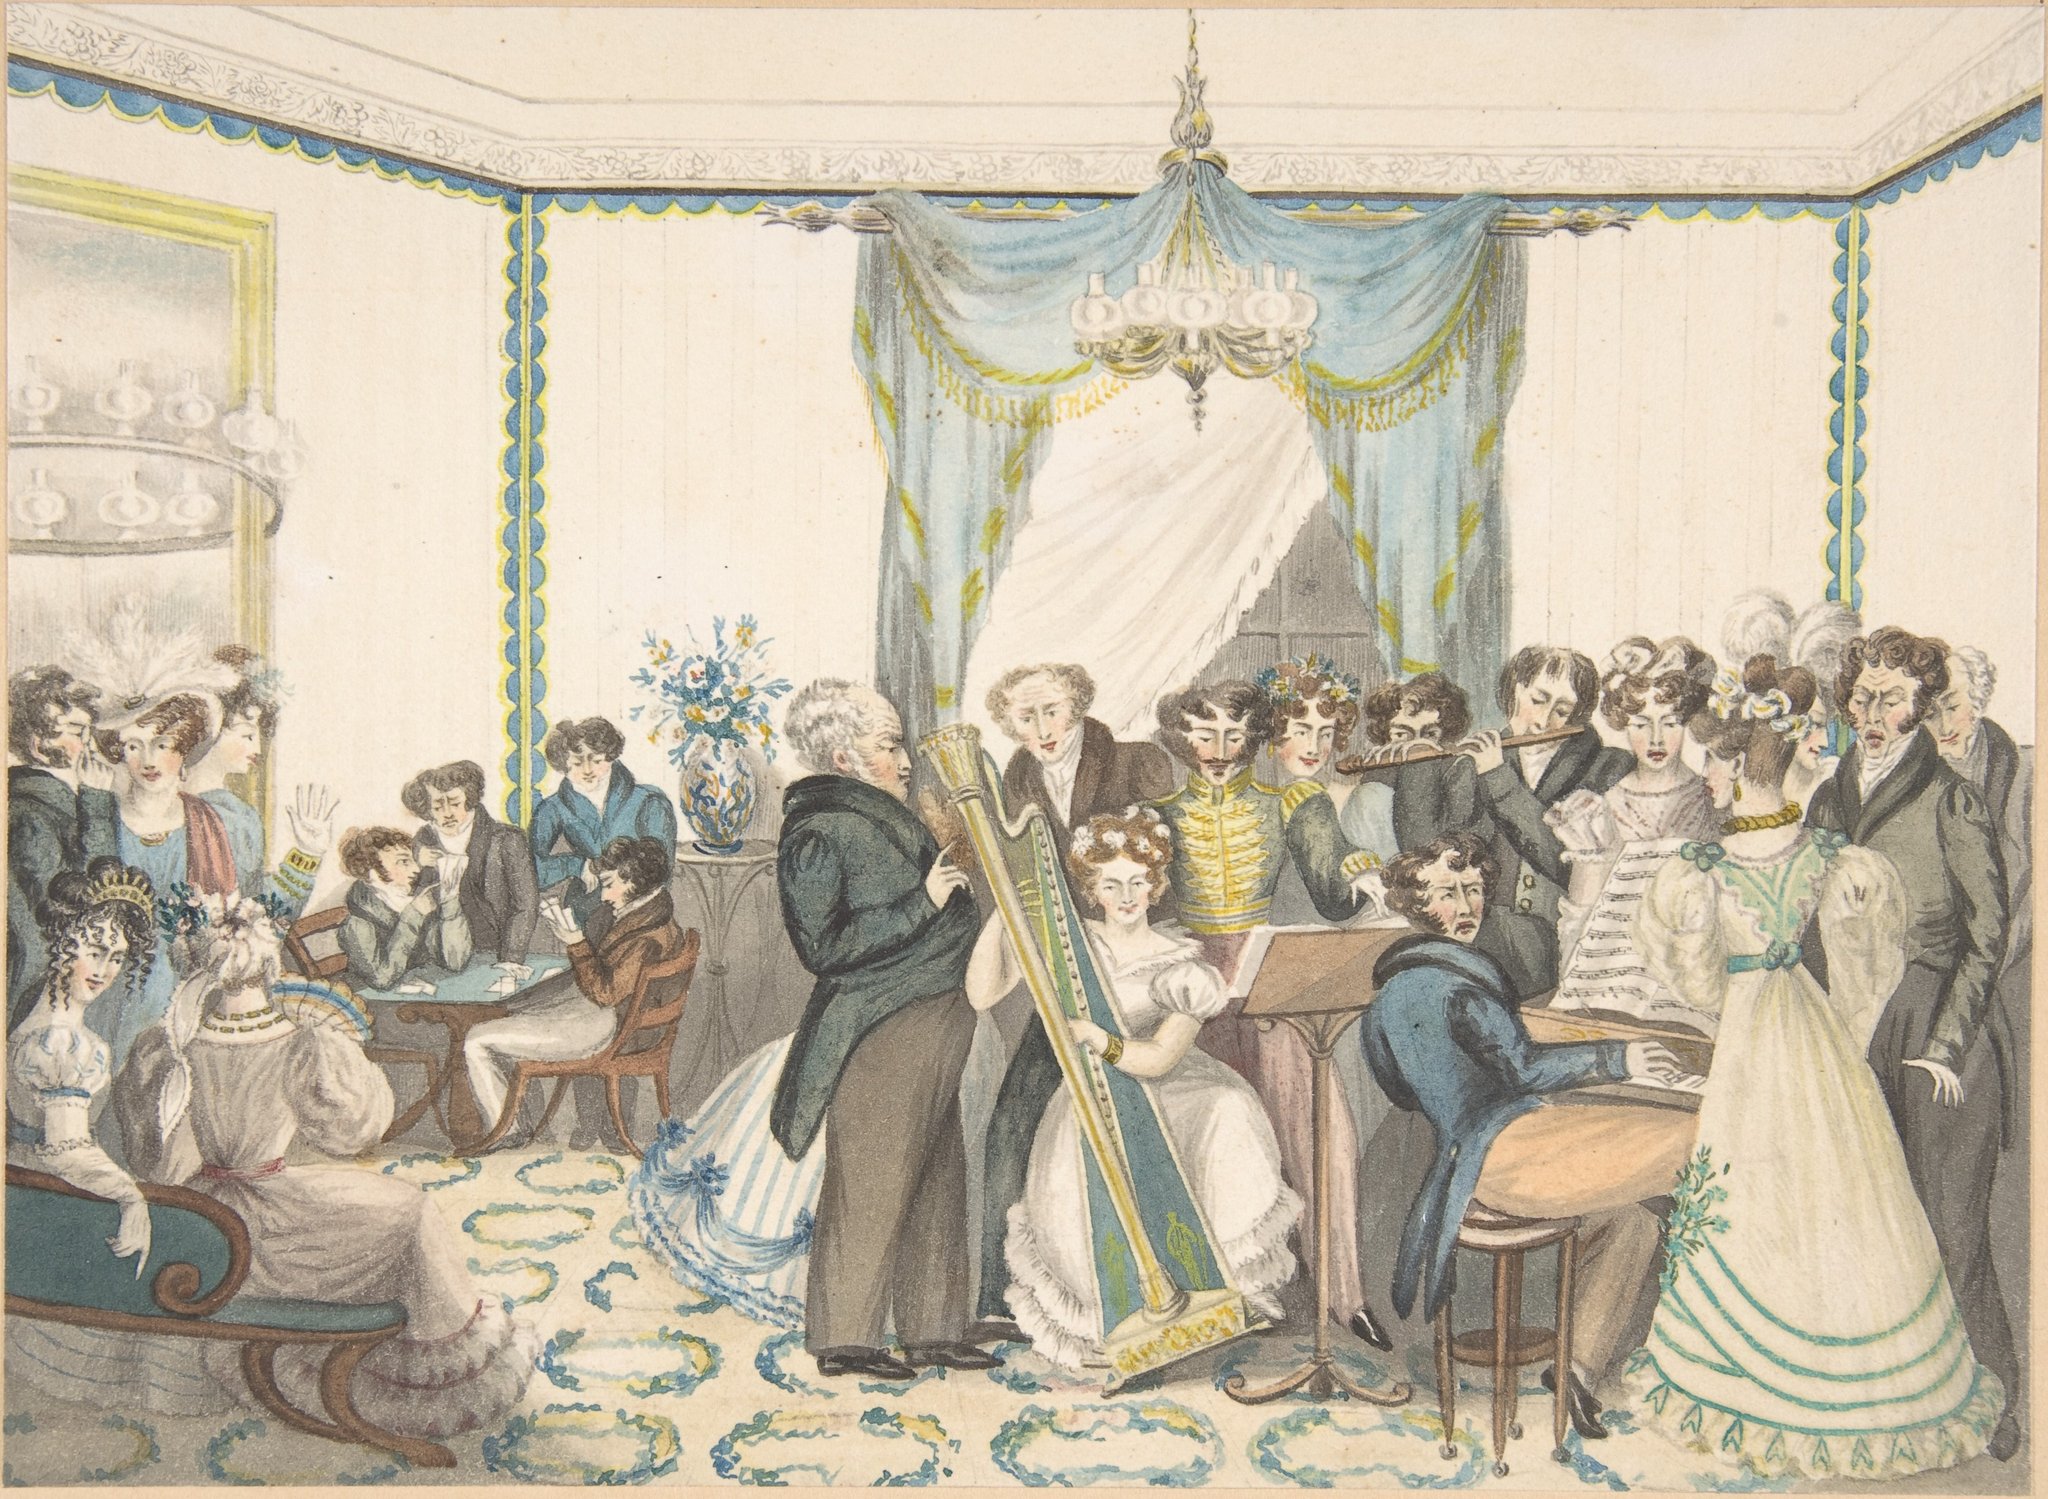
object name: drawing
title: A Concert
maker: granddaughters of dr. samuel parr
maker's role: artist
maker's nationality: british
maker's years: 1800-1830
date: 1820-1830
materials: watercolor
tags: men,women,concerts,flutes,harps